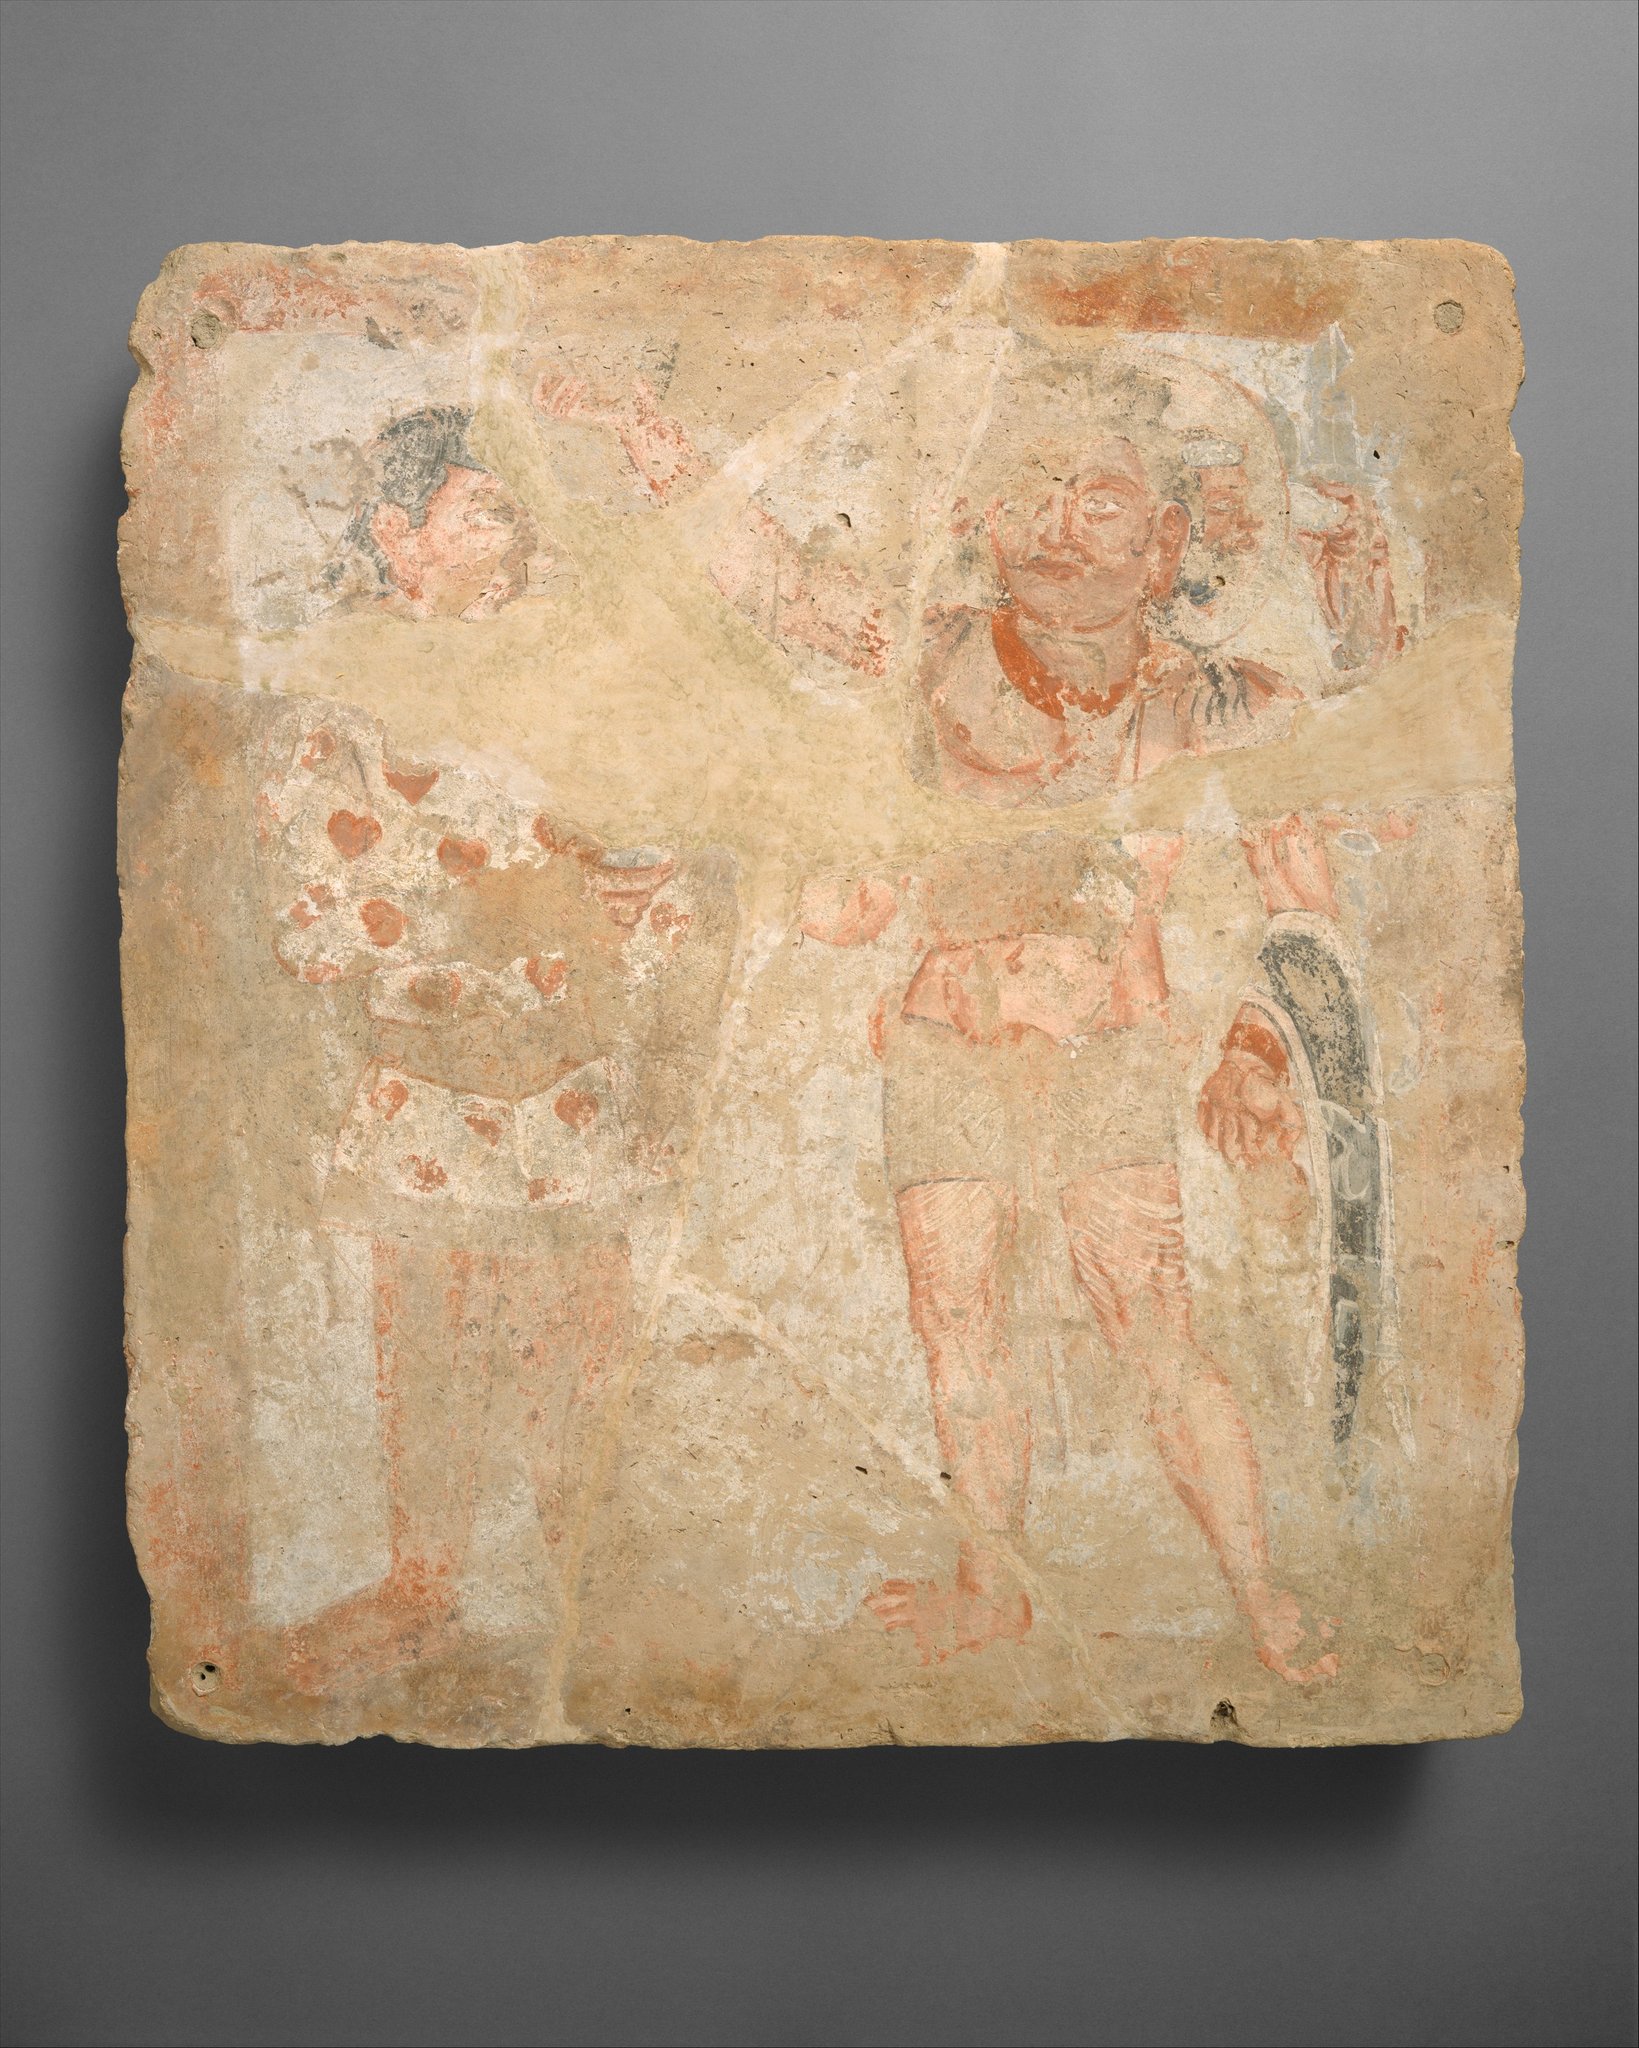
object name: painted panel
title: Panel with the god Shiva/Oesho and worshiper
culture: kushan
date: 201-300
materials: gouache, terracotta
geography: bactria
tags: men,shiva